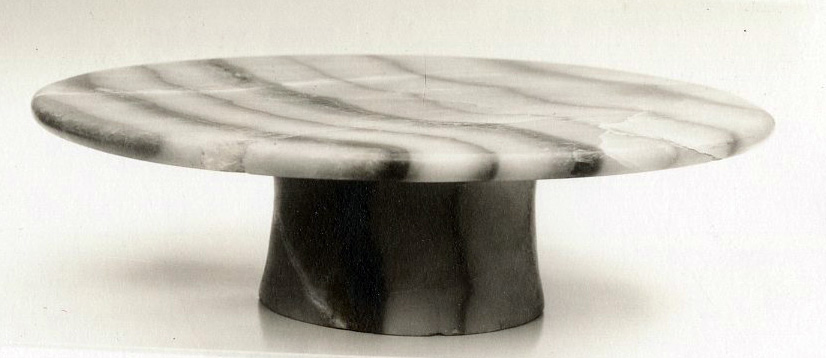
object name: offering table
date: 2960-2649 BCE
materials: stone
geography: egypt